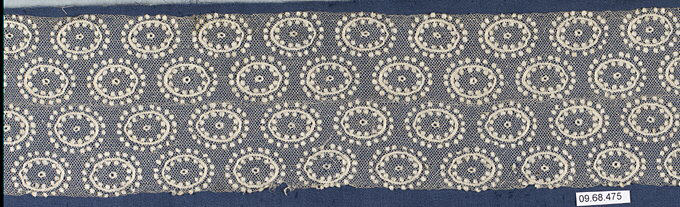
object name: insertion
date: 1801-1900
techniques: lace